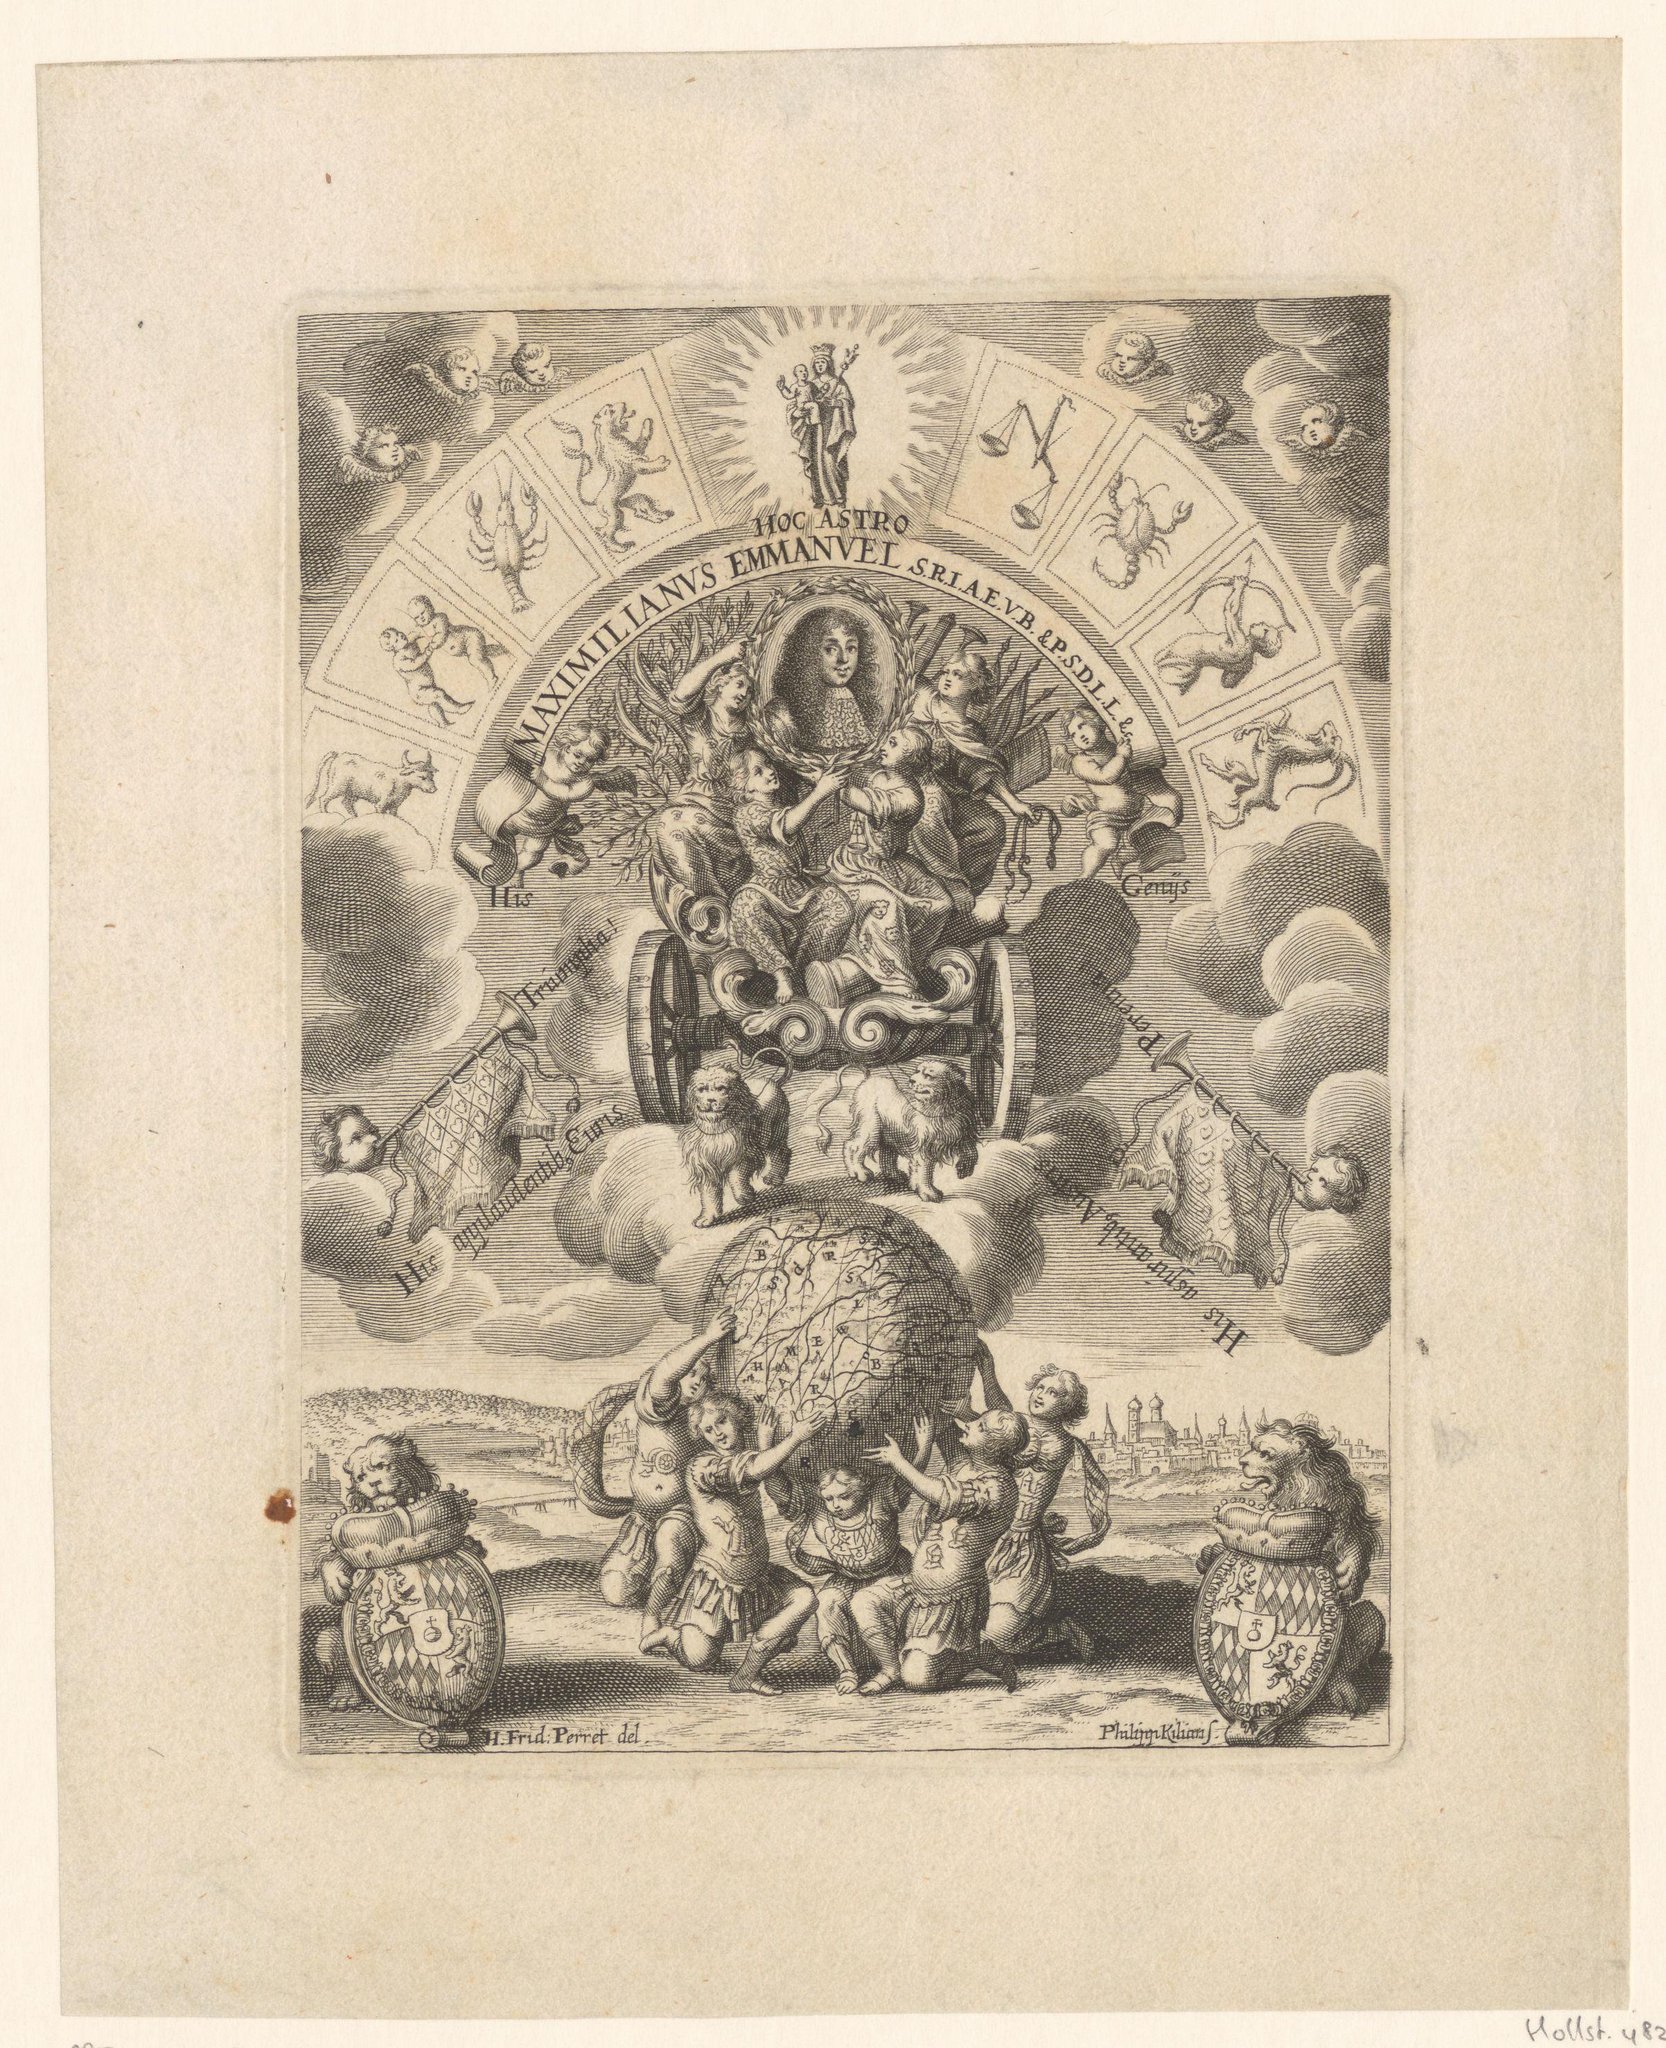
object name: print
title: Allegorische voorstelling met portret van Maximiliaan II Emanuel van Beieren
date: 1672-1693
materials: paper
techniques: engraving, etching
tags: maximiliaan ii emanuel (keurvorst van beieren), zodiacal signs of the summer season, historical persons, ruler, sovereign, zodiacal signs of the autumn season, globe, roman chariot, quadriga ~ triumph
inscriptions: collector's mark: Lugt 2228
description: Het portretmedaillon wordt ondersteund door personificaties van de vier seizoenen op een koets getrokken door leeuwen. Daaronder een wereldbol, omhoog gehouden door soldaten. Bovenaan acht sterrenbeelden en Maria met kind centraal. Leeuwen met wapenschilden onderaan.